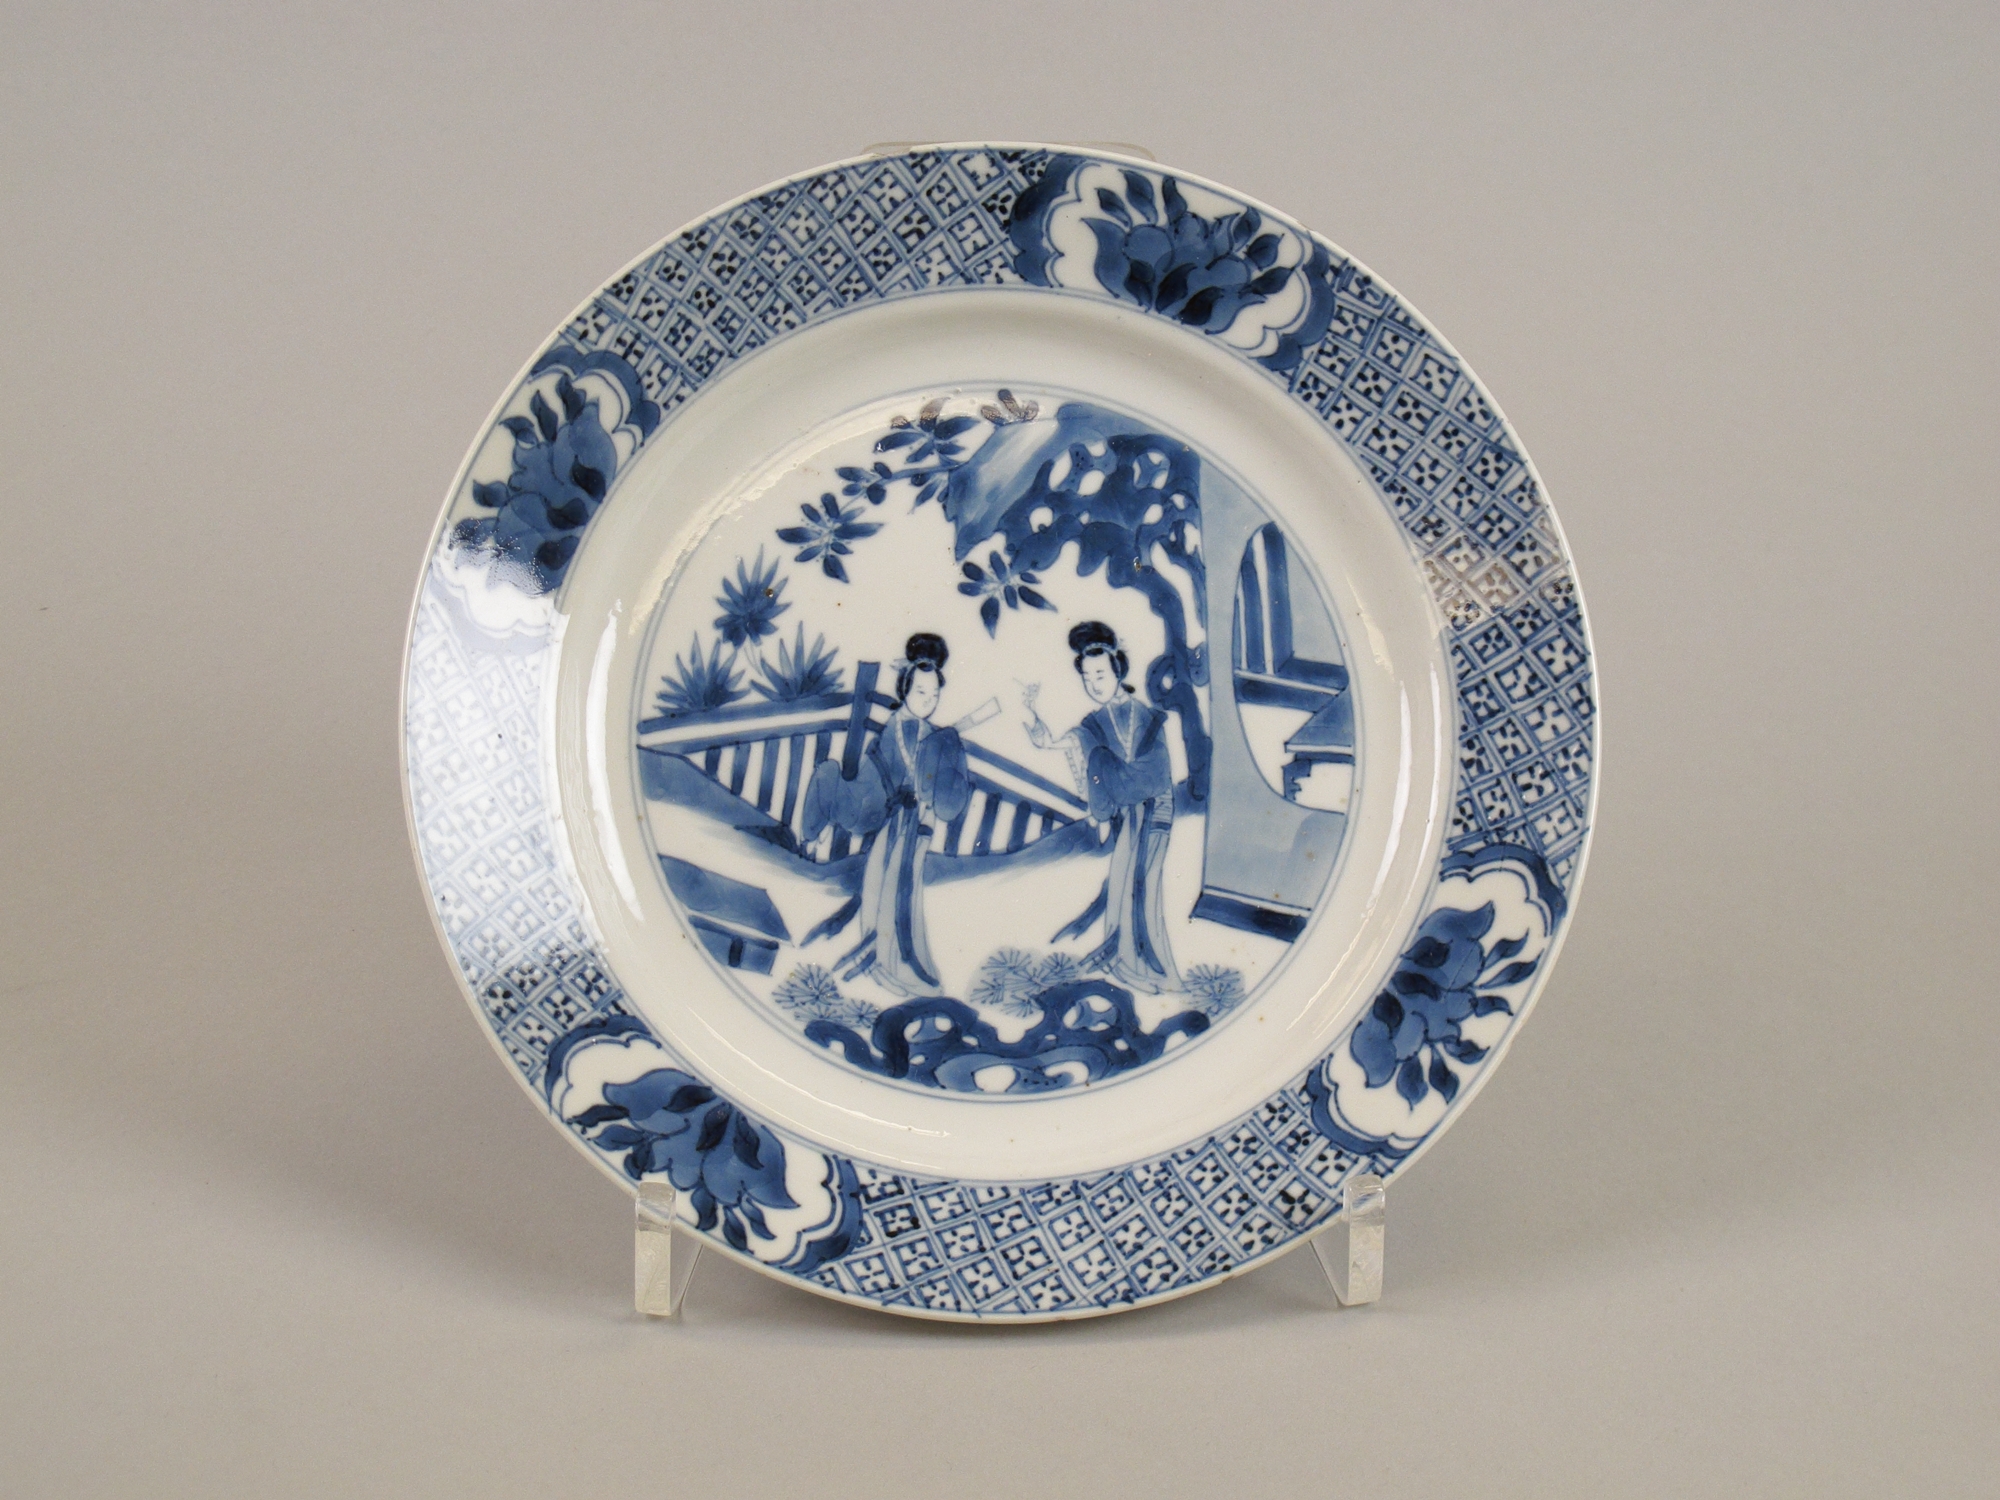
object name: plate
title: Plate with two ladies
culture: chinese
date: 1667-1733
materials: cobalt, porcelain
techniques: painting, underglaze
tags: human figures,flowers